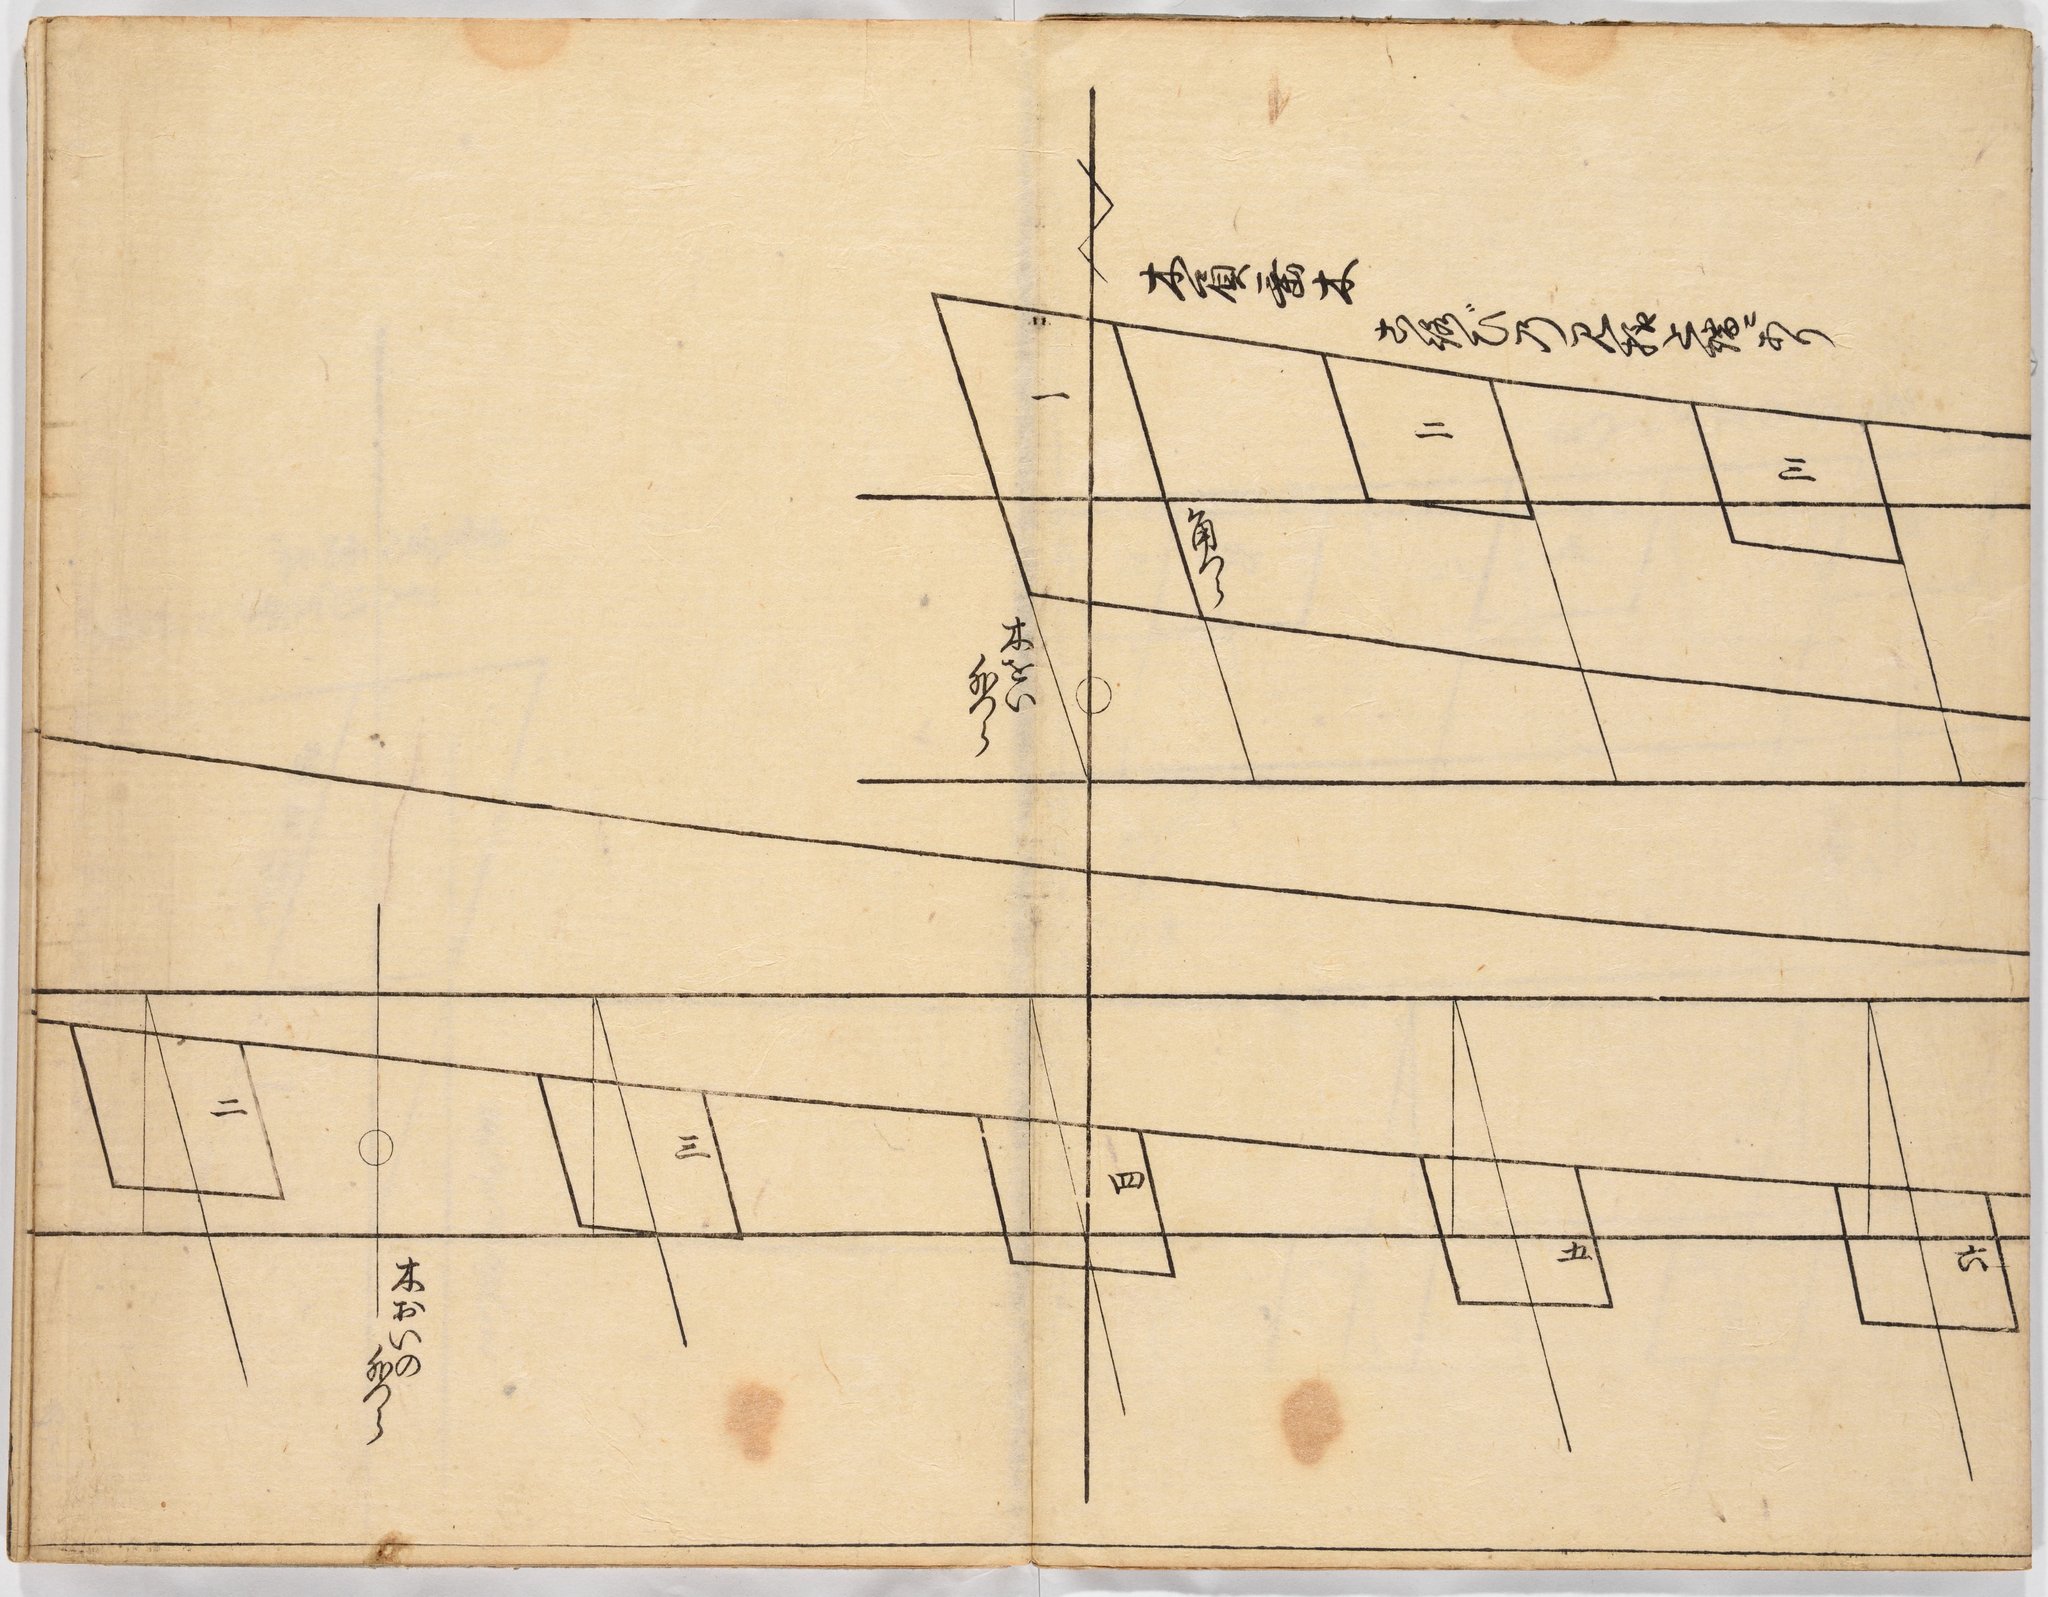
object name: illustrated book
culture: japanese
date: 1893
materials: ink, paper